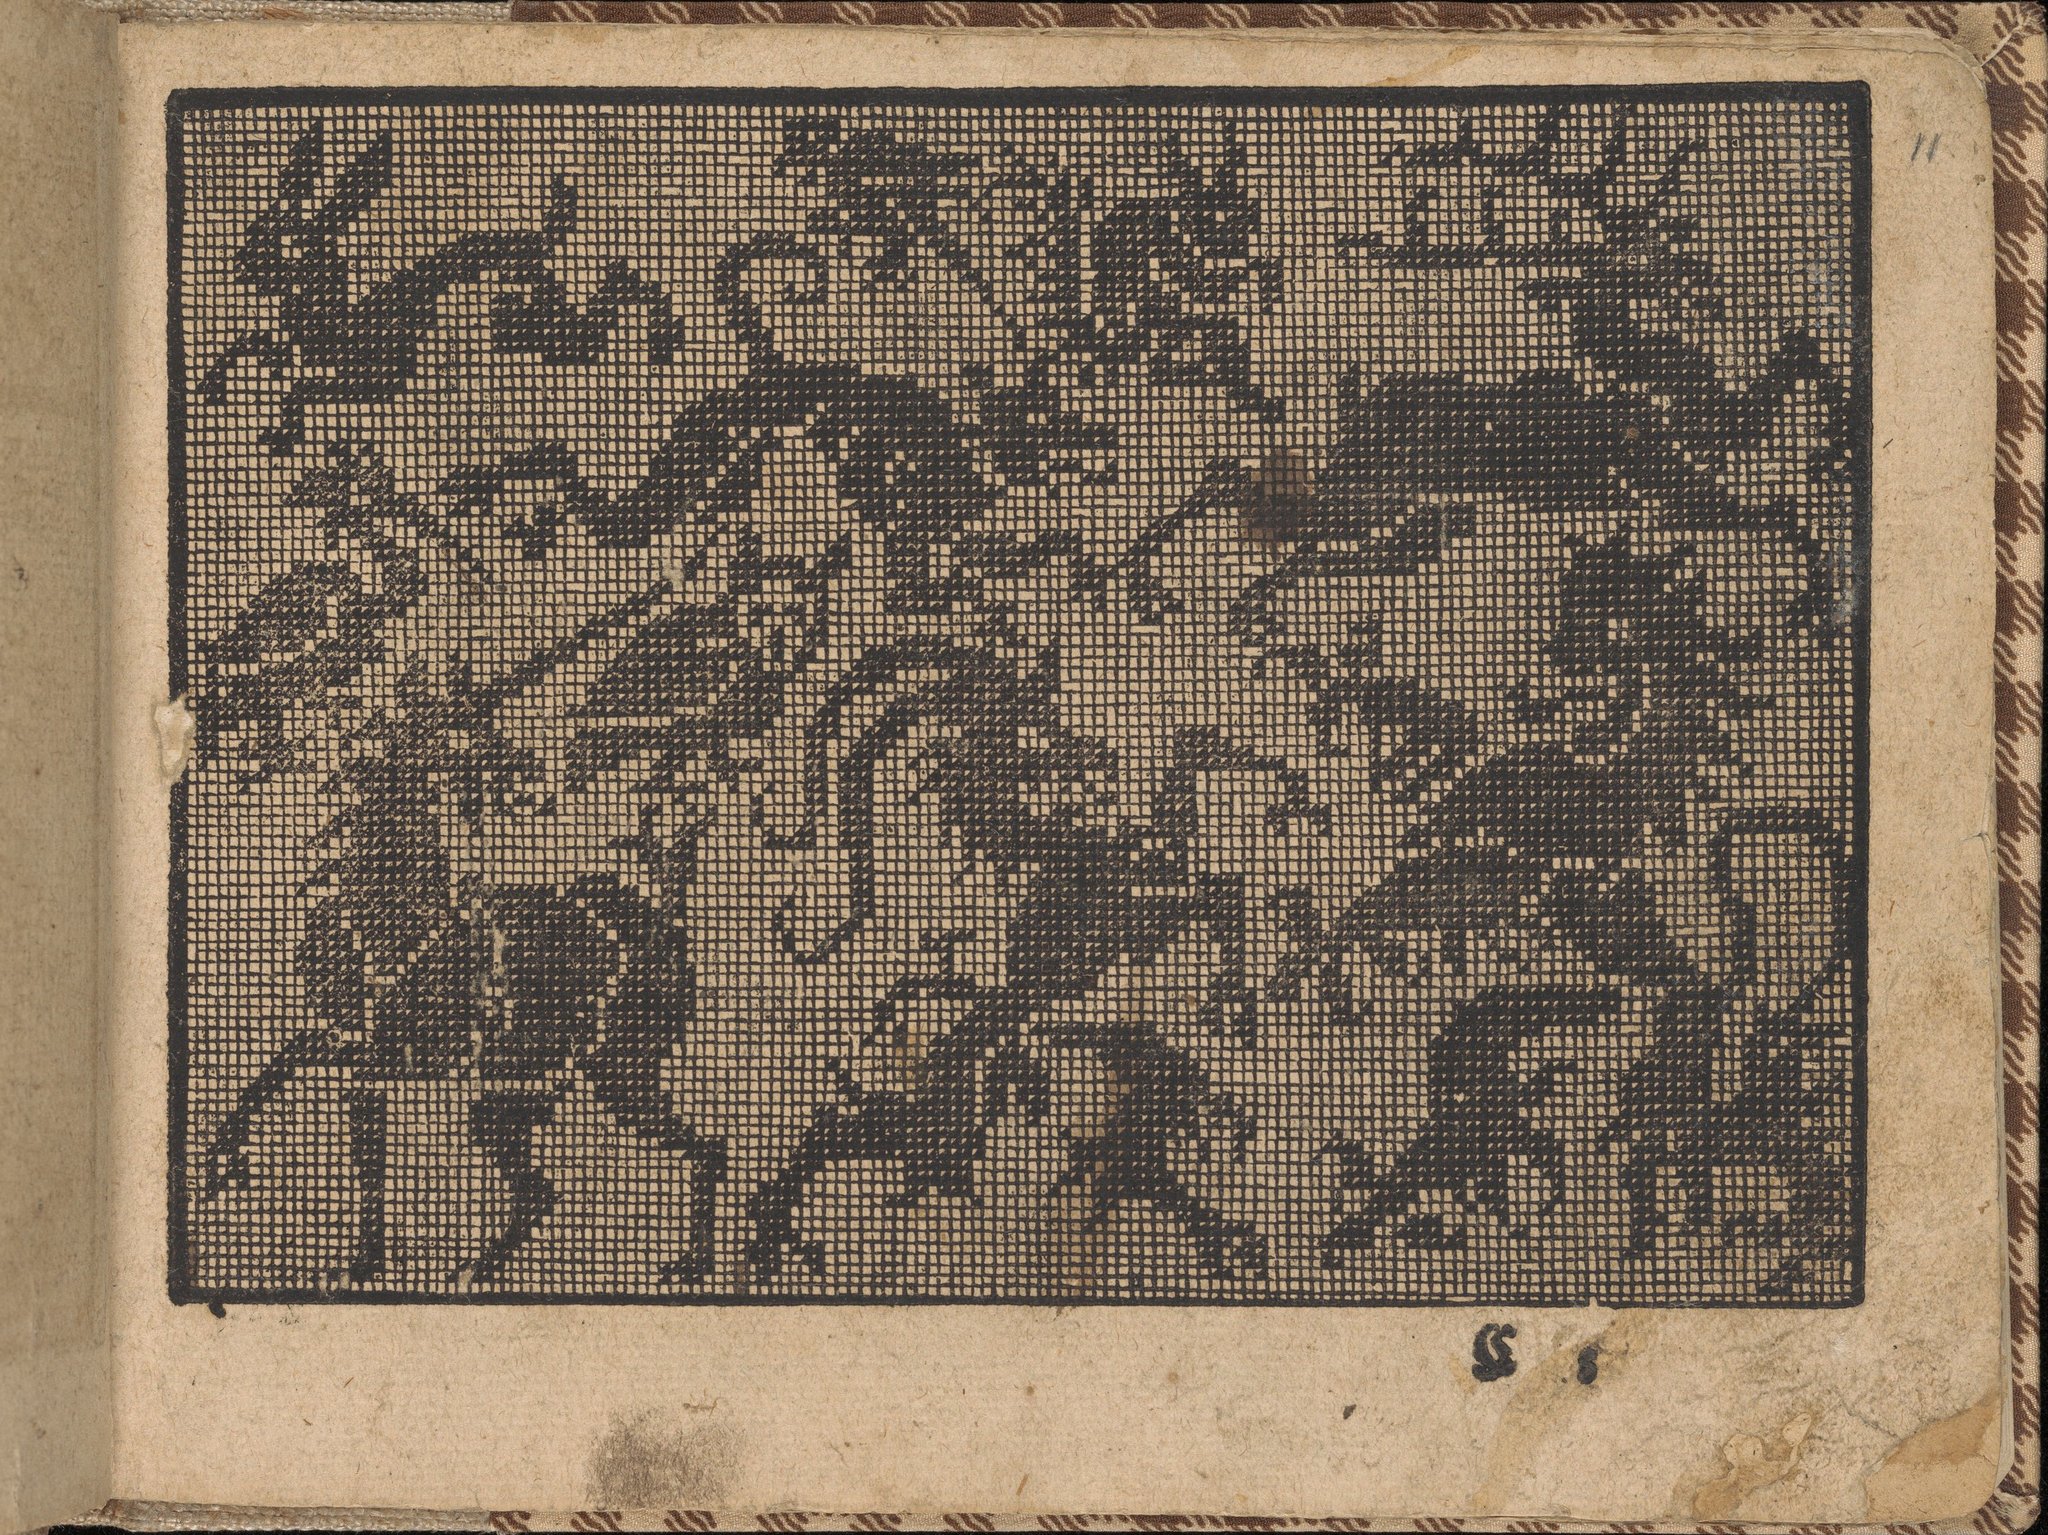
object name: book print ornament architecture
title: New Künstlichs Modelbuch (Page 11 recto)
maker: bernhard jobin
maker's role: publisher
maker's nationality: swiss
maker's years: 1535-1597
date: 1600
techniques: woodcut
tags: animals,birds